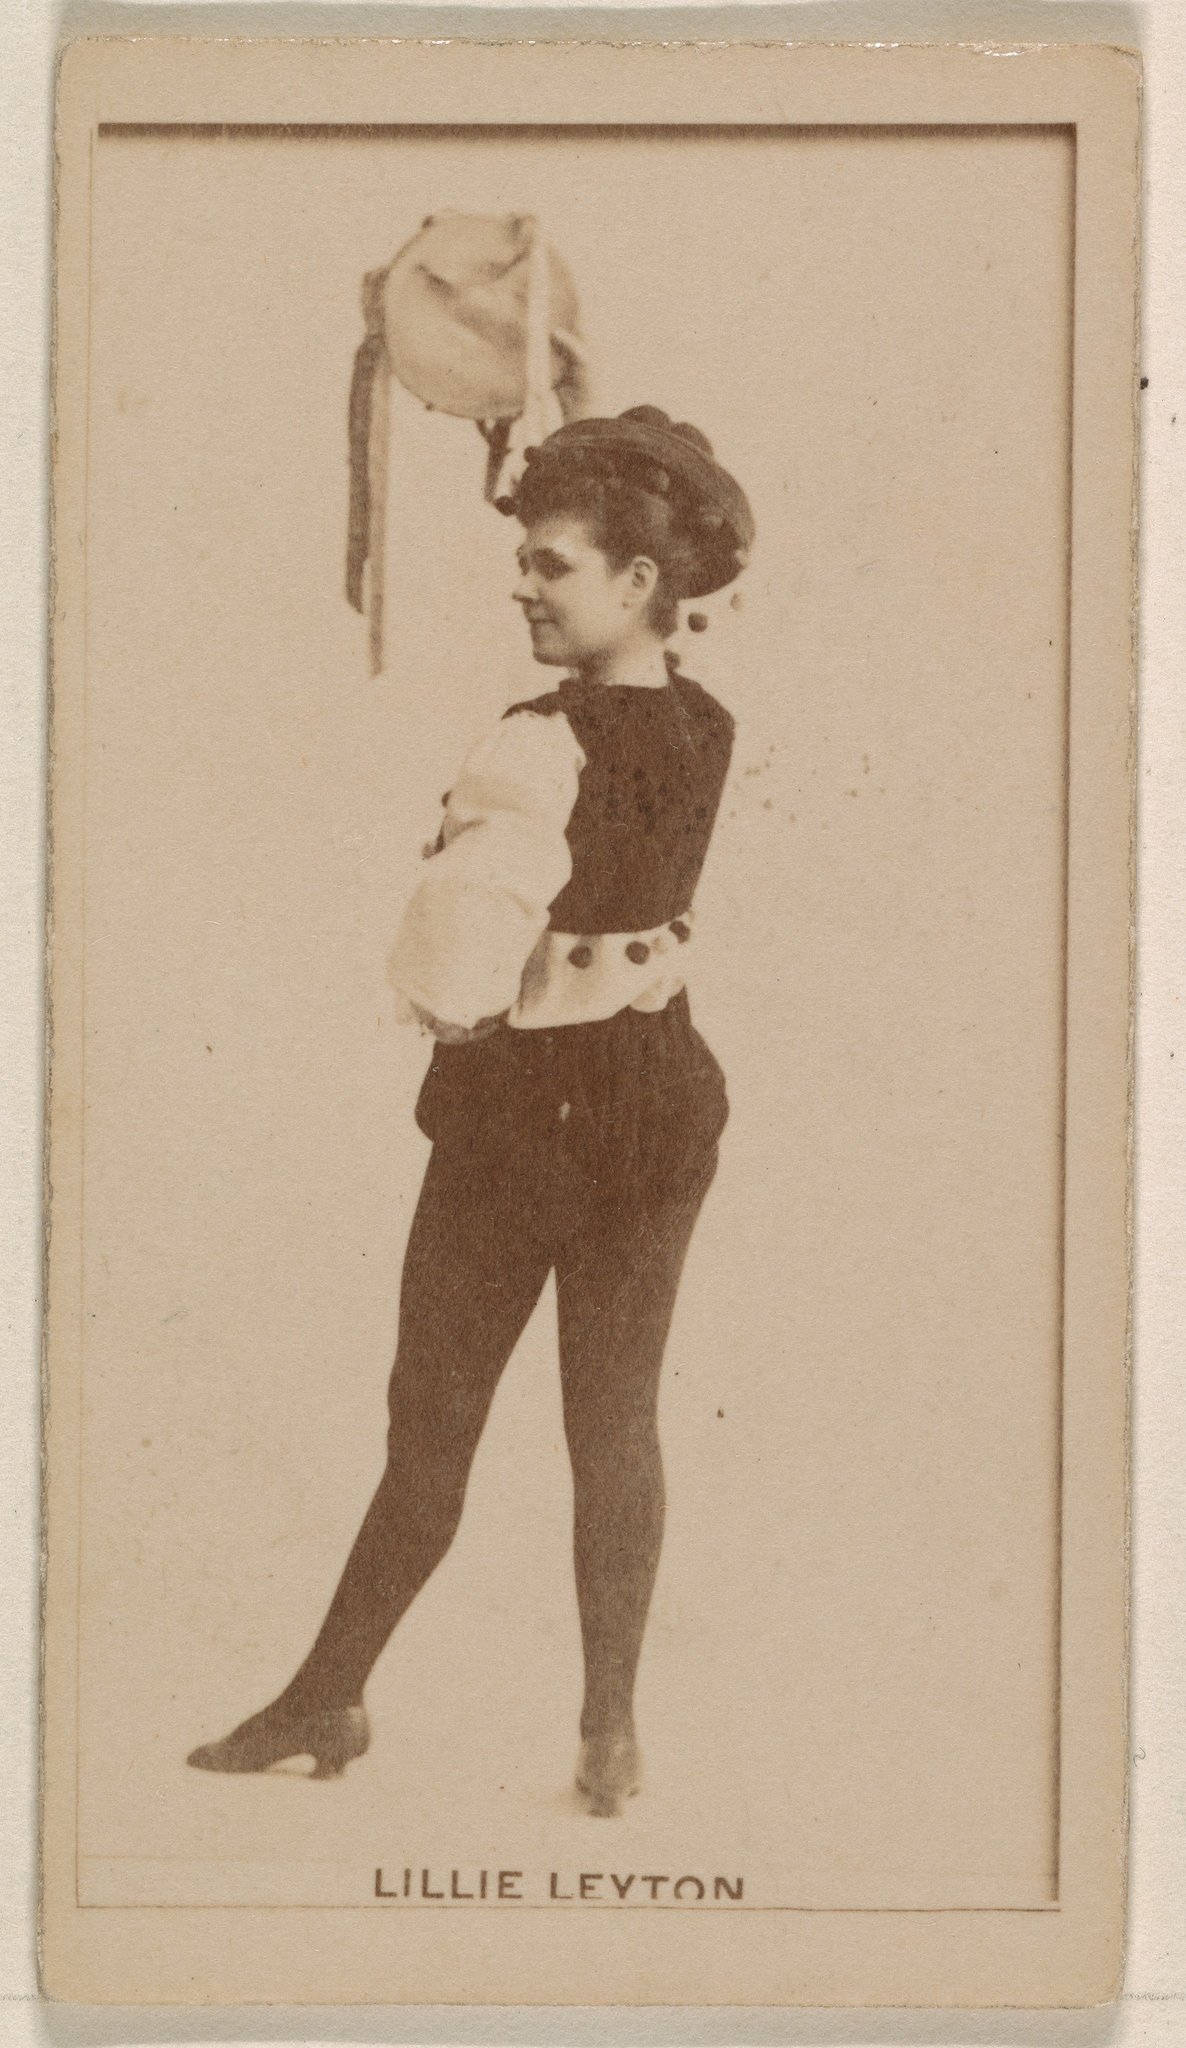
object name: photograph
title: Lillie Leyton, from the Actresses series (N245) issued by Kinney Brothers to promote Sweet Caporal Cigarettes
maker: kinney brothers tobacco company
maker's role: publisher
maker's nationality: american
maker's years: 1869-2011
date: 1890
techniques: albumen silver print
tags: women,actresses